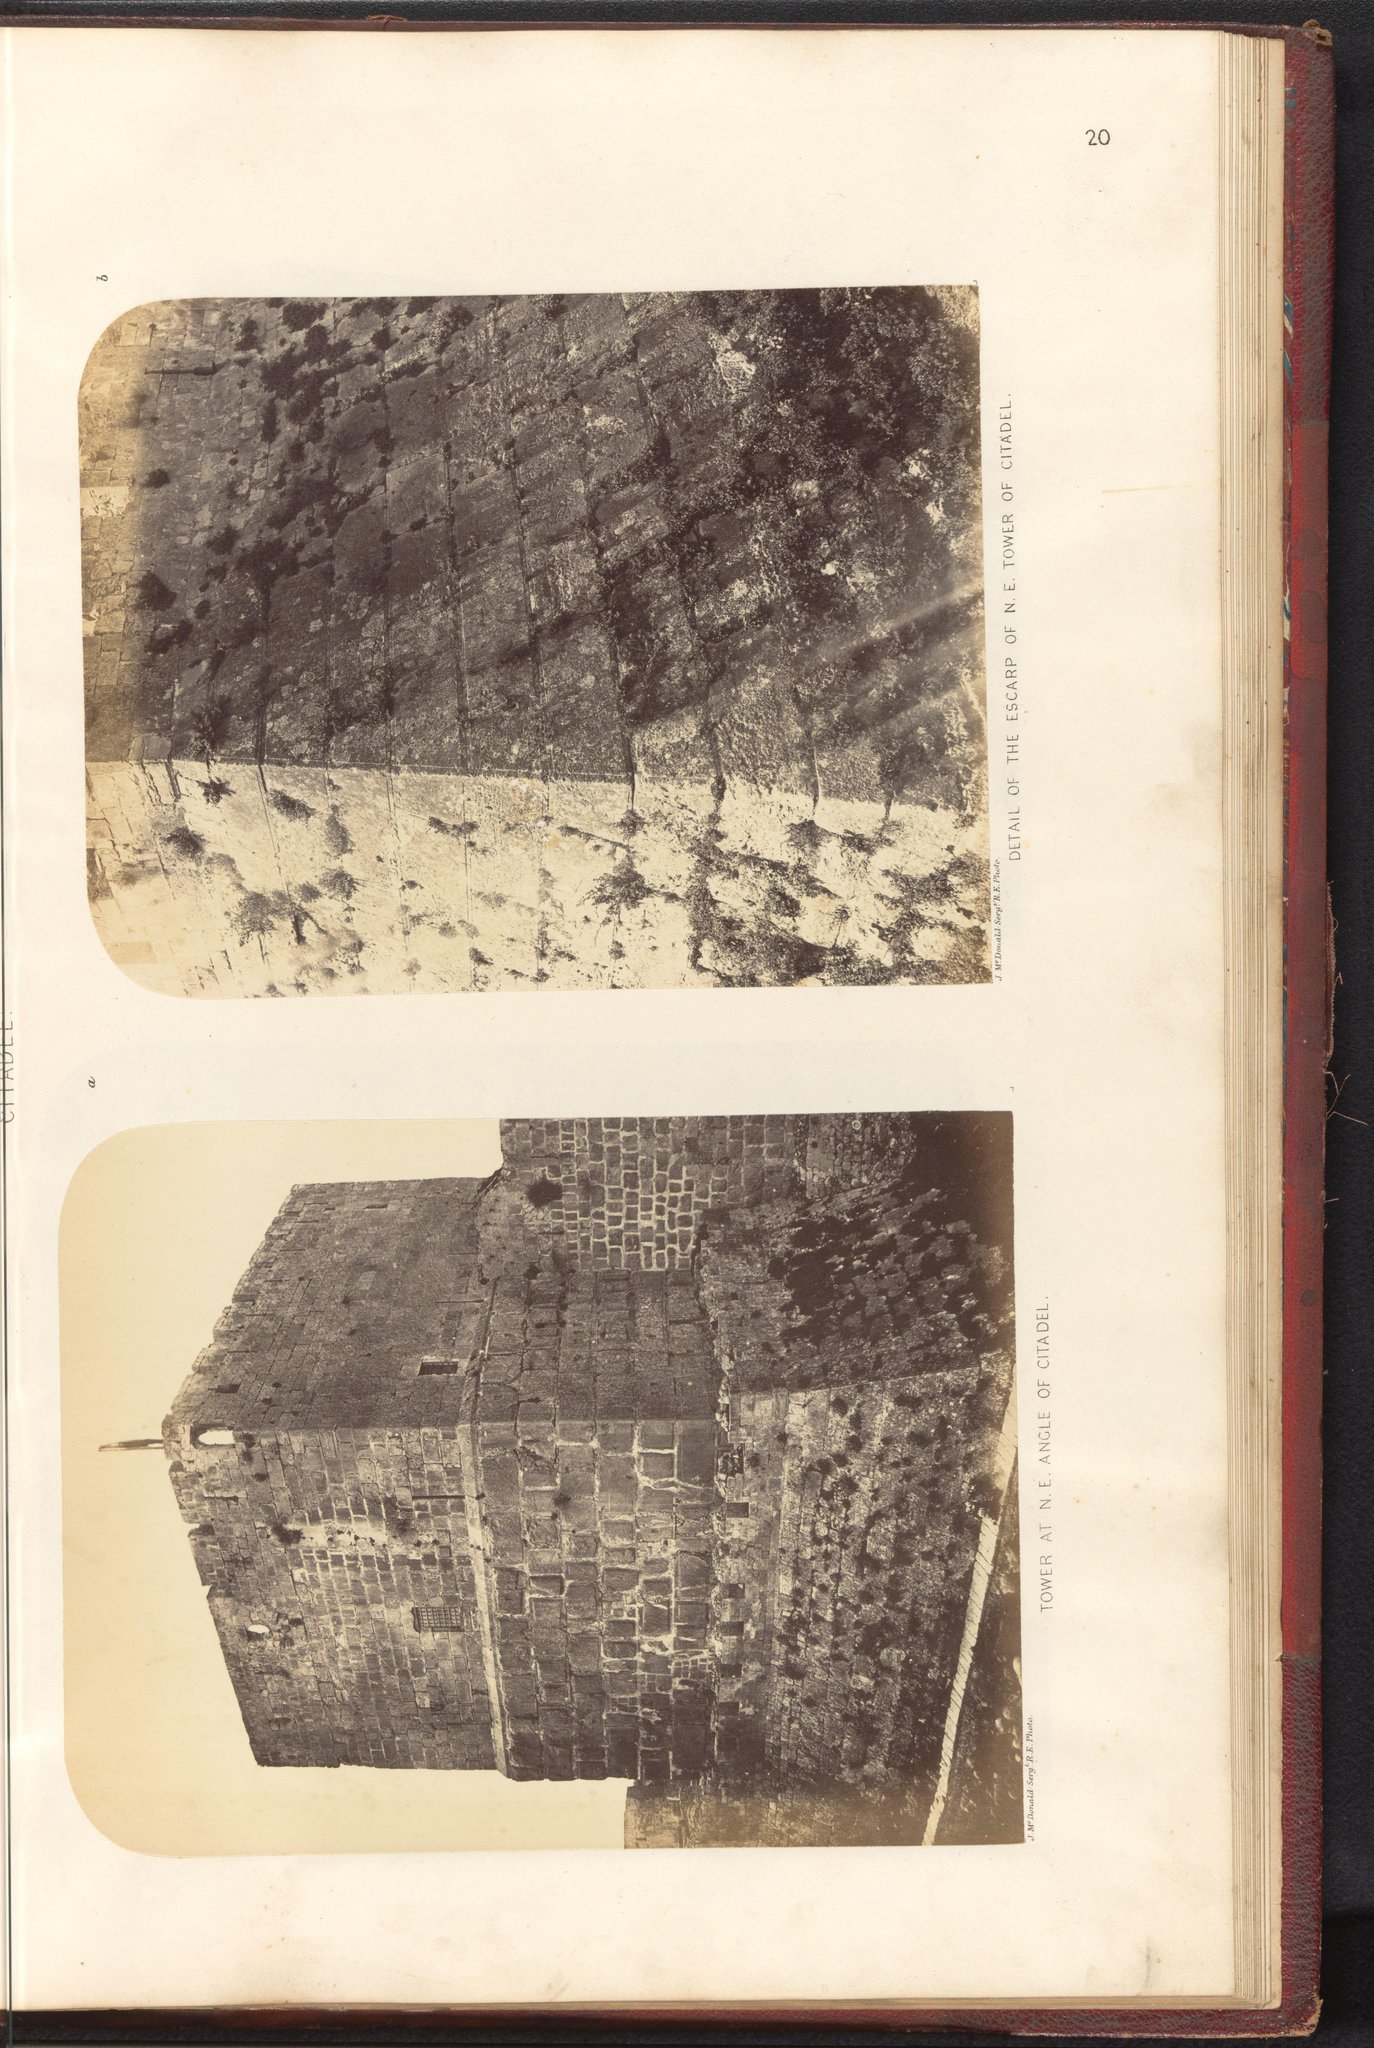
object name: page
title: Twee gezichten op de noordoostelijke toren van de citadel van Jeruzalem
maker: james mcdonald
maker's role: fotograaf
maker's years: 1822-1885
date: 1860-1865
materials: paper, photographic support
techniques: albumen print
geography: jerusalem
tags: fortified city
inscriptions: inscription: ‘a’, inscription: ‘b’